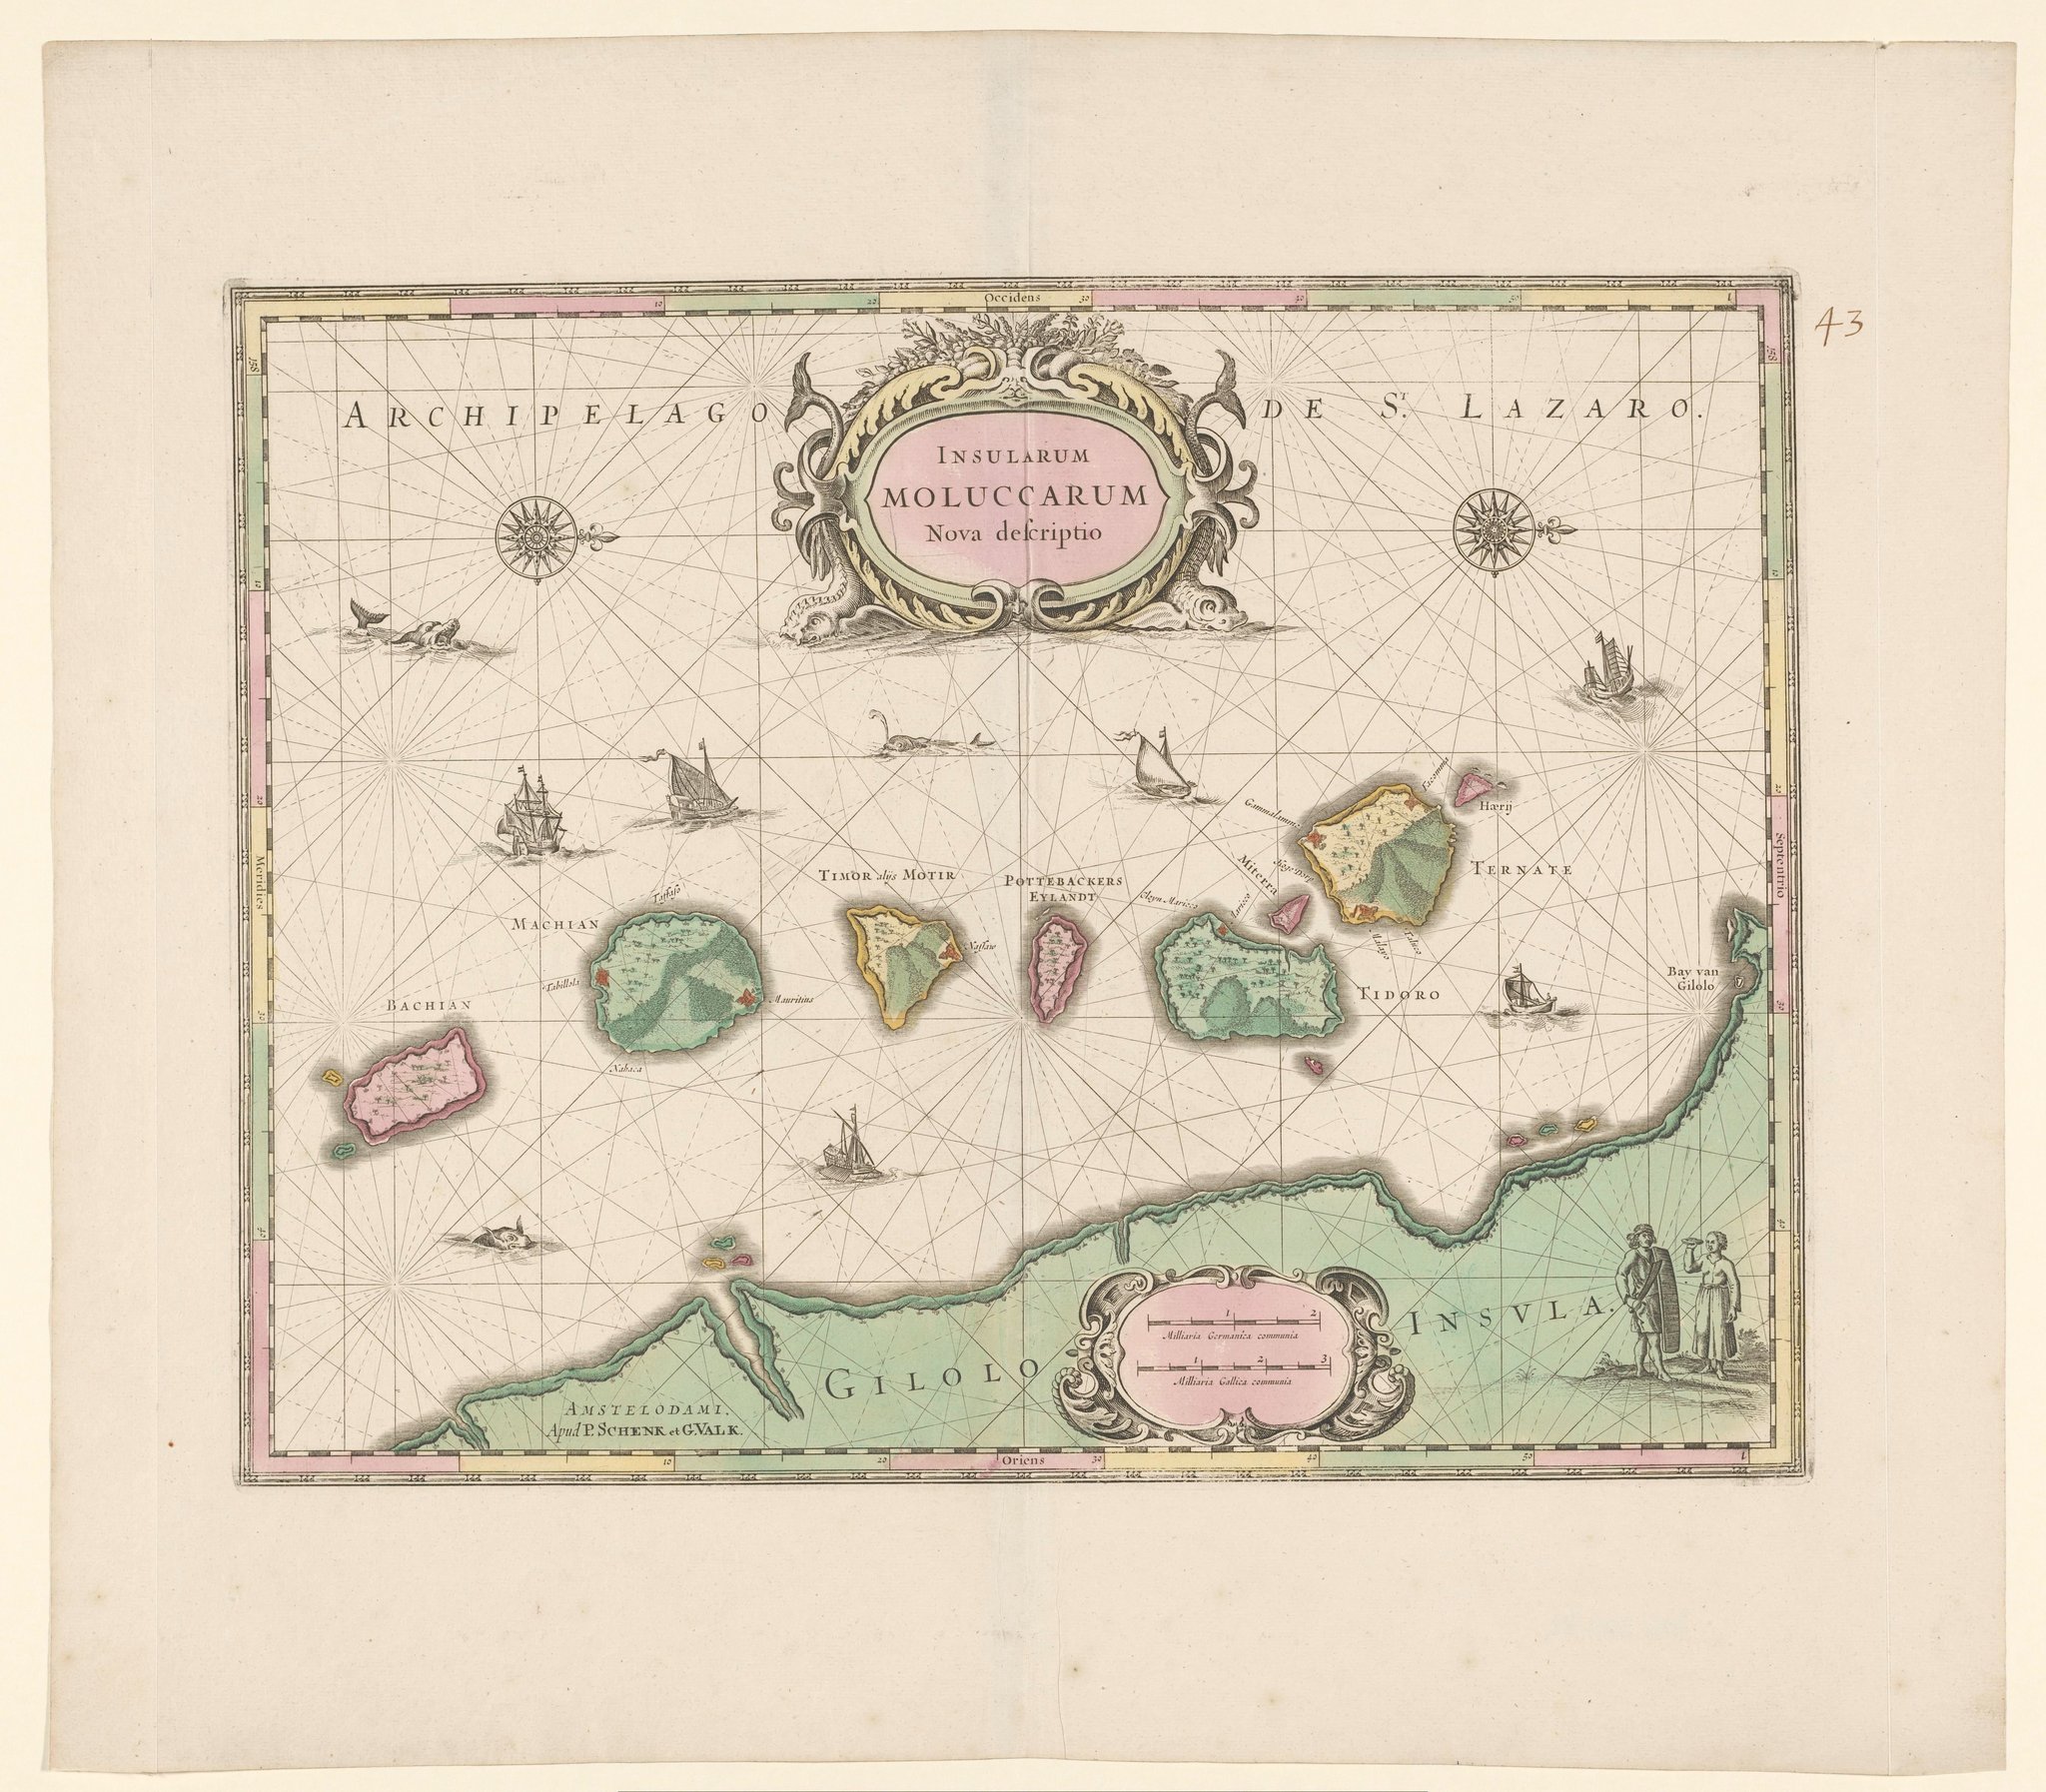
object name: print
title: Kaart van de Noord-Molukken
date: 1670-1726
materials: paint, paper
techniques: engraving, etching, hand coloring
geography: northern netherlands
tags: maps of separate countries or regions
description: Kaart van zes eilanden van de noordelijke Molukkenen een deel van een groter eiland 'Gilolo' (Halmahera). Middenboven cartouche met titel en twee visssen, onderaan cartouche met twee schalen, rechts twee staande lokale figuren. In de zee het opschrift 'Archipelago de St. Lazaro'.